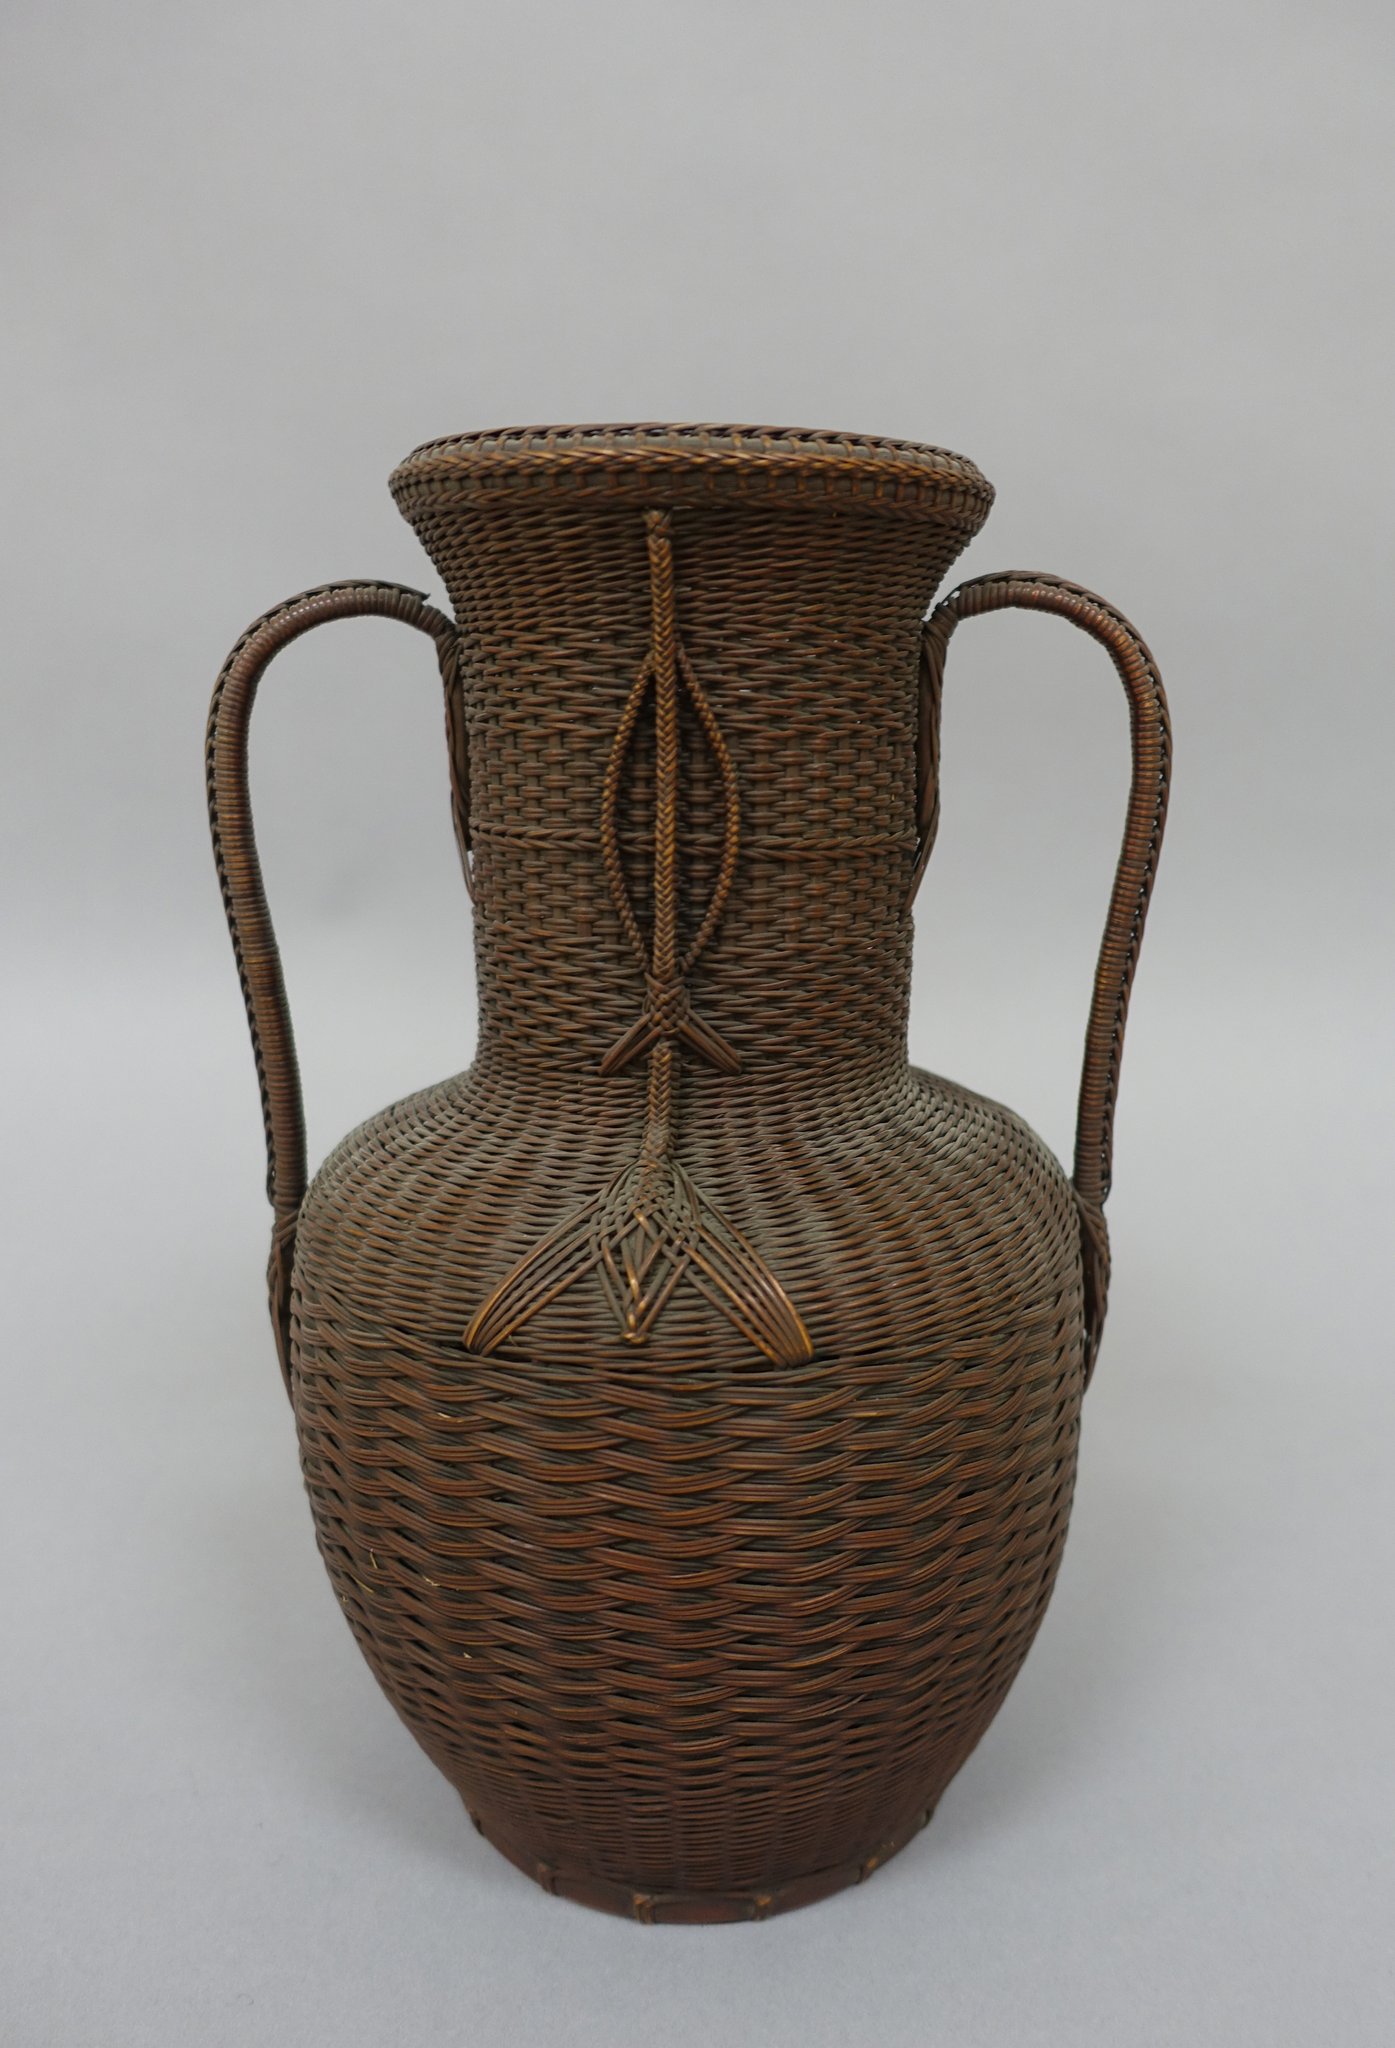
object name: basket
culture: japanese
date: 1801-1900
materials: bamboo